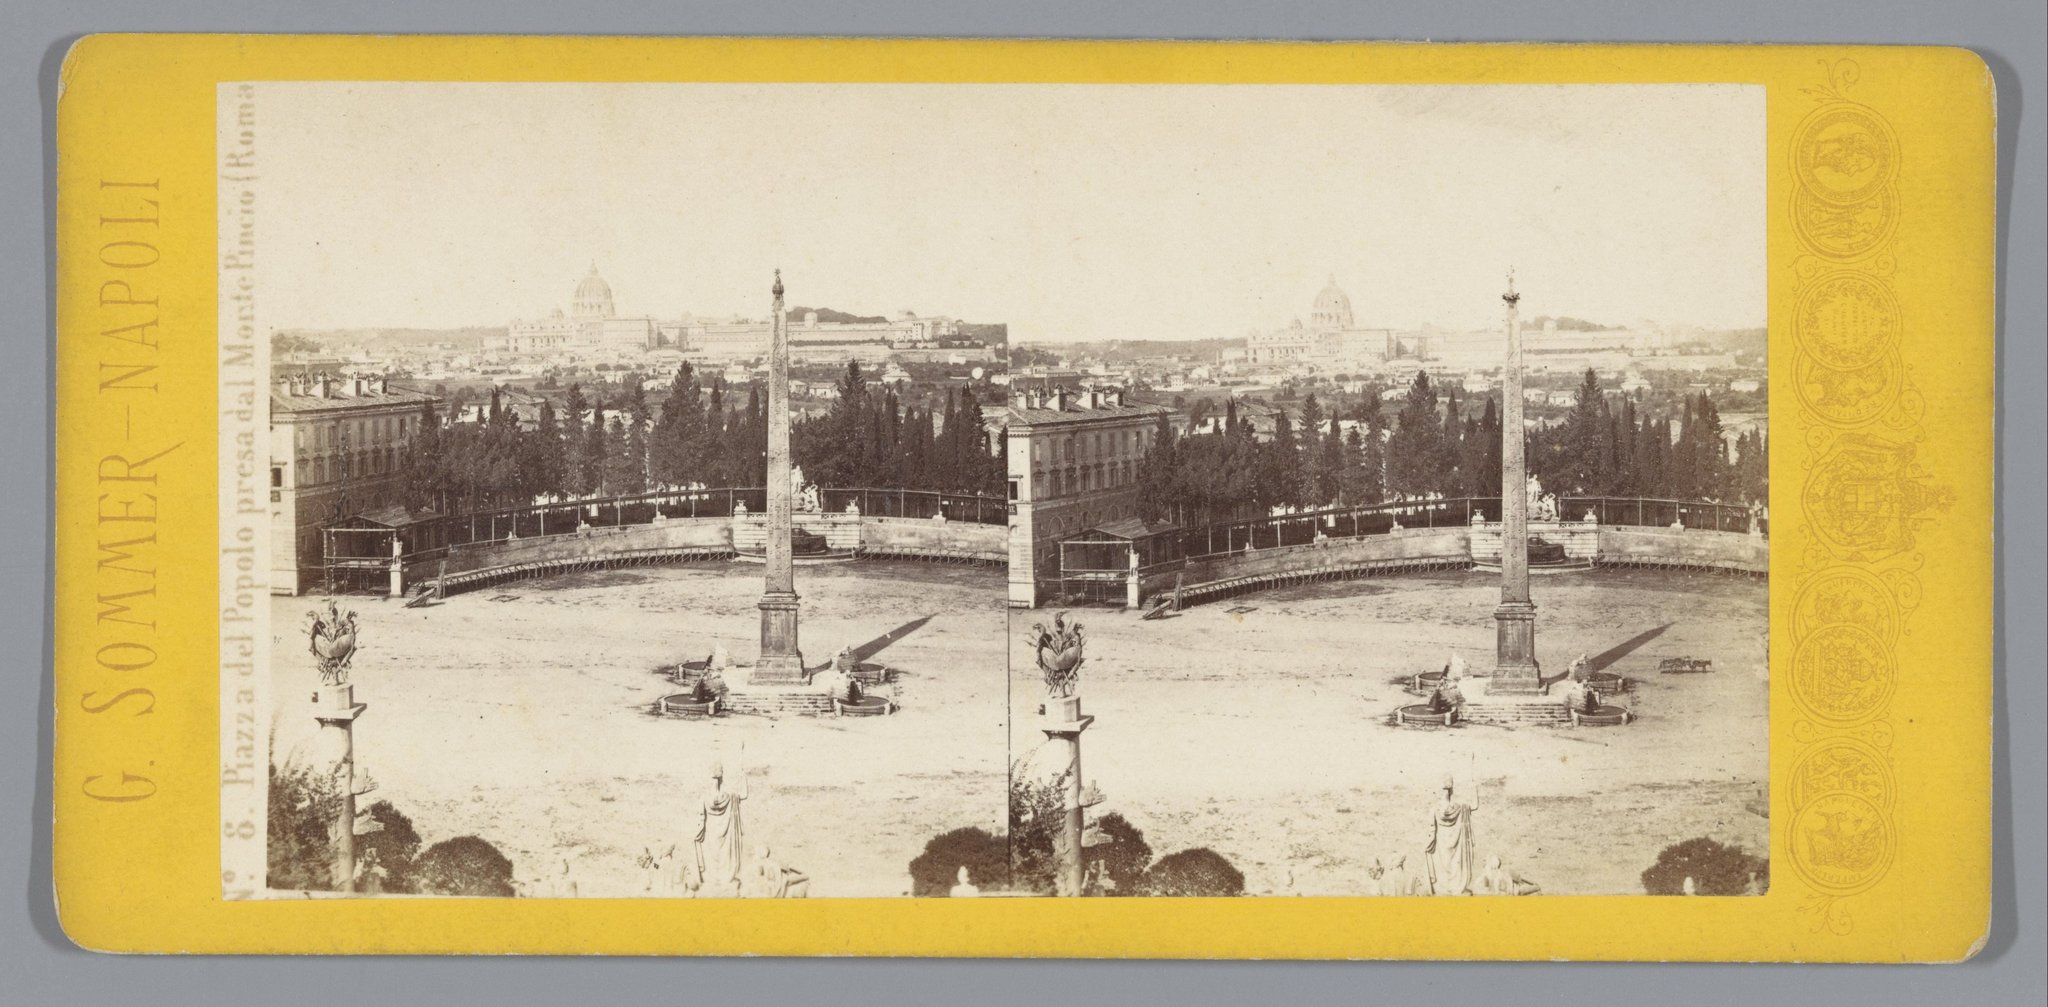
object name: stereograph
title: Gezicht op het Piazza del Popolo in Rome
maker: giorgio sommer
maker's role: fotograaf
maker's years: 1834-1914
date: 1860-1880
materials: cardboard, photographic support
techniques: albumen print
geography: rome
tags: square, place, circus, etc.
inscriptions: number: ‘No. 8.’